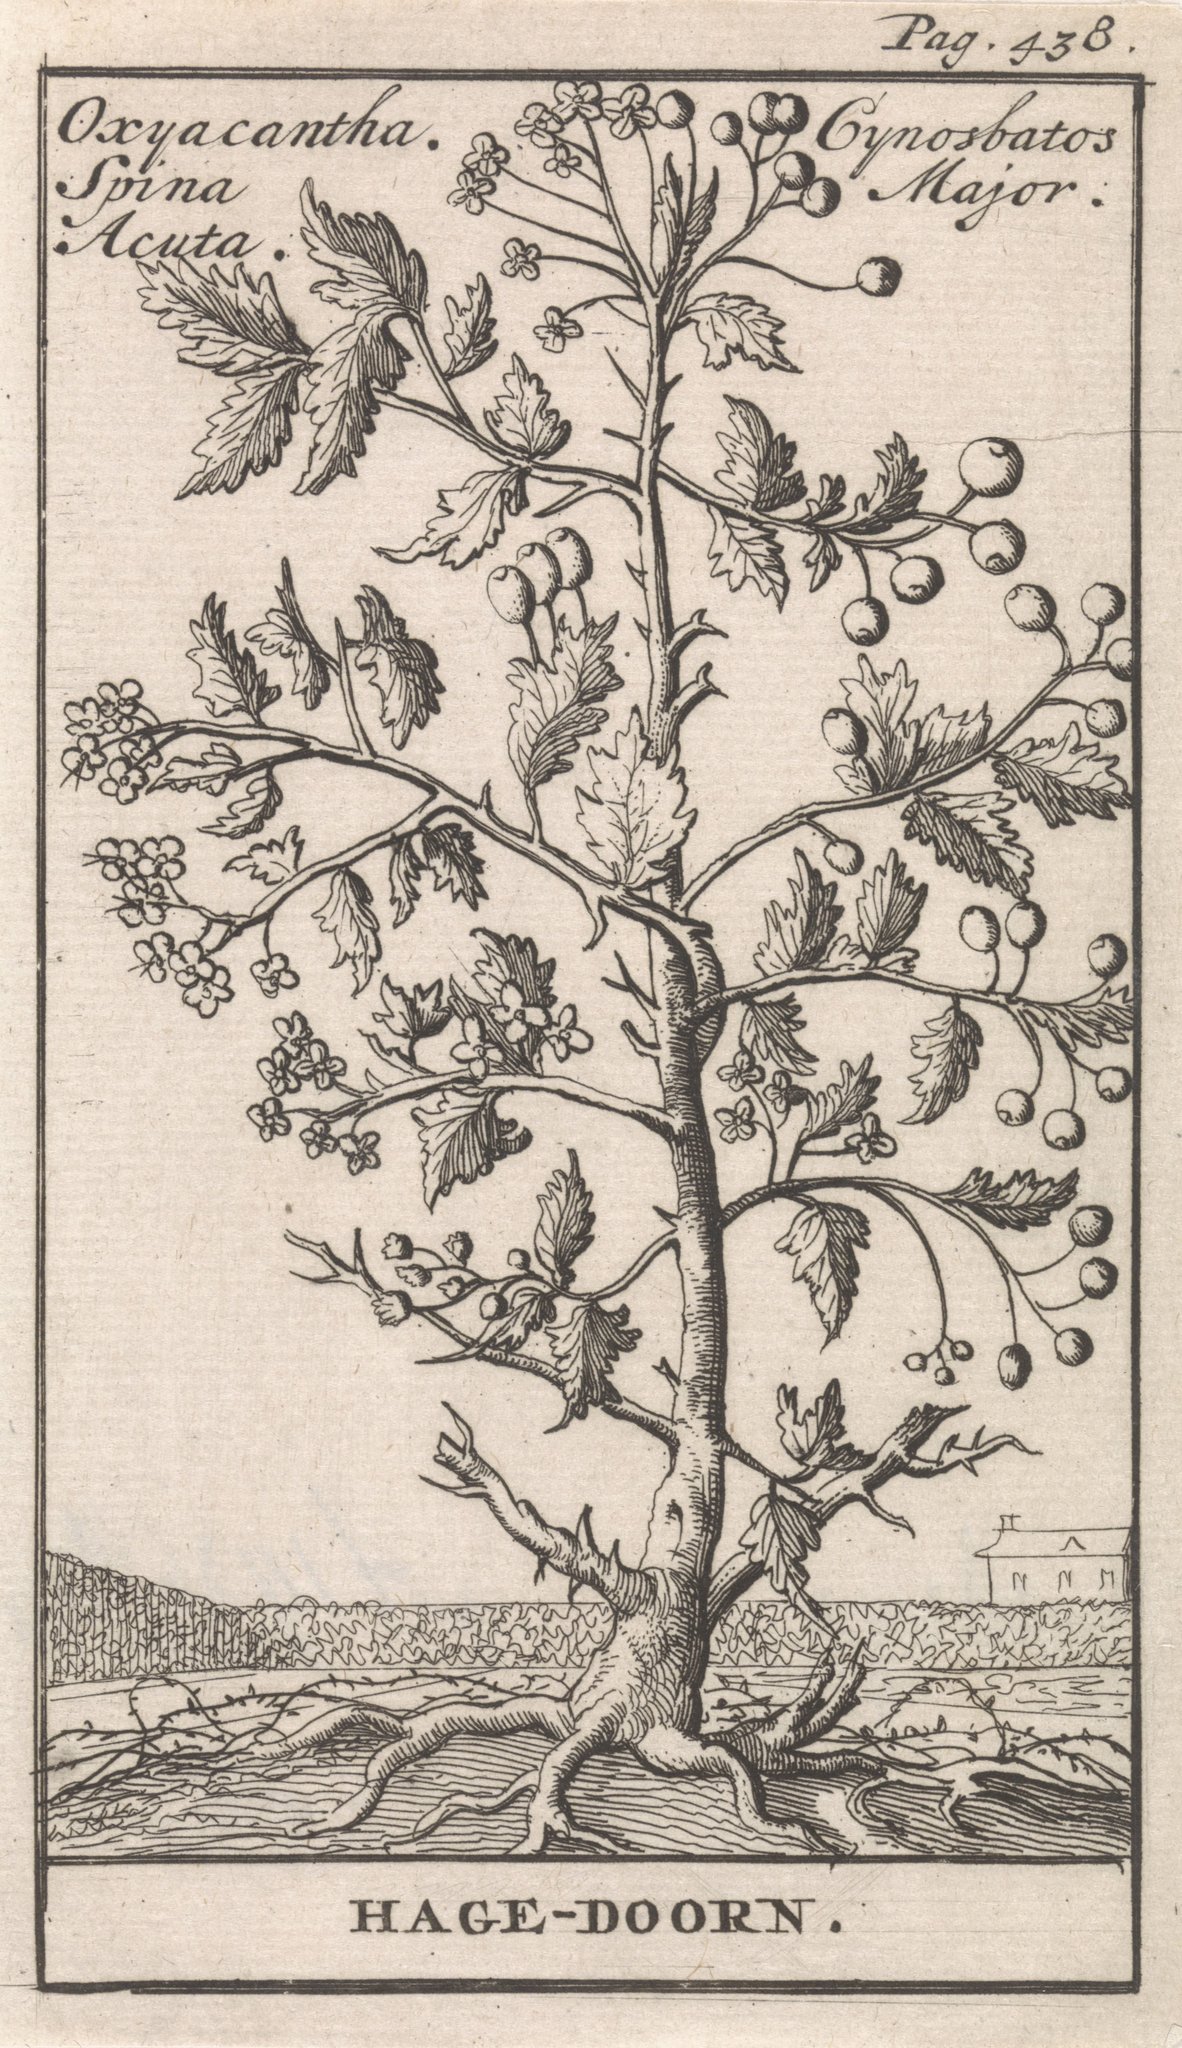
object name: print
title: Hagedoorn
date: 1698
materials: paper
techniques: etching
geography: amsterdam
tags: plants and herbs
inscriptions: collector's mark: Lugt 2228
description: Illustratie uit: Blankaart, Steven. Den Neder-landschen herbarius ofte Kruid-boek der voornaamste kruiden. Amsterdam: Jan Claesz ten Hoorn, 1698.